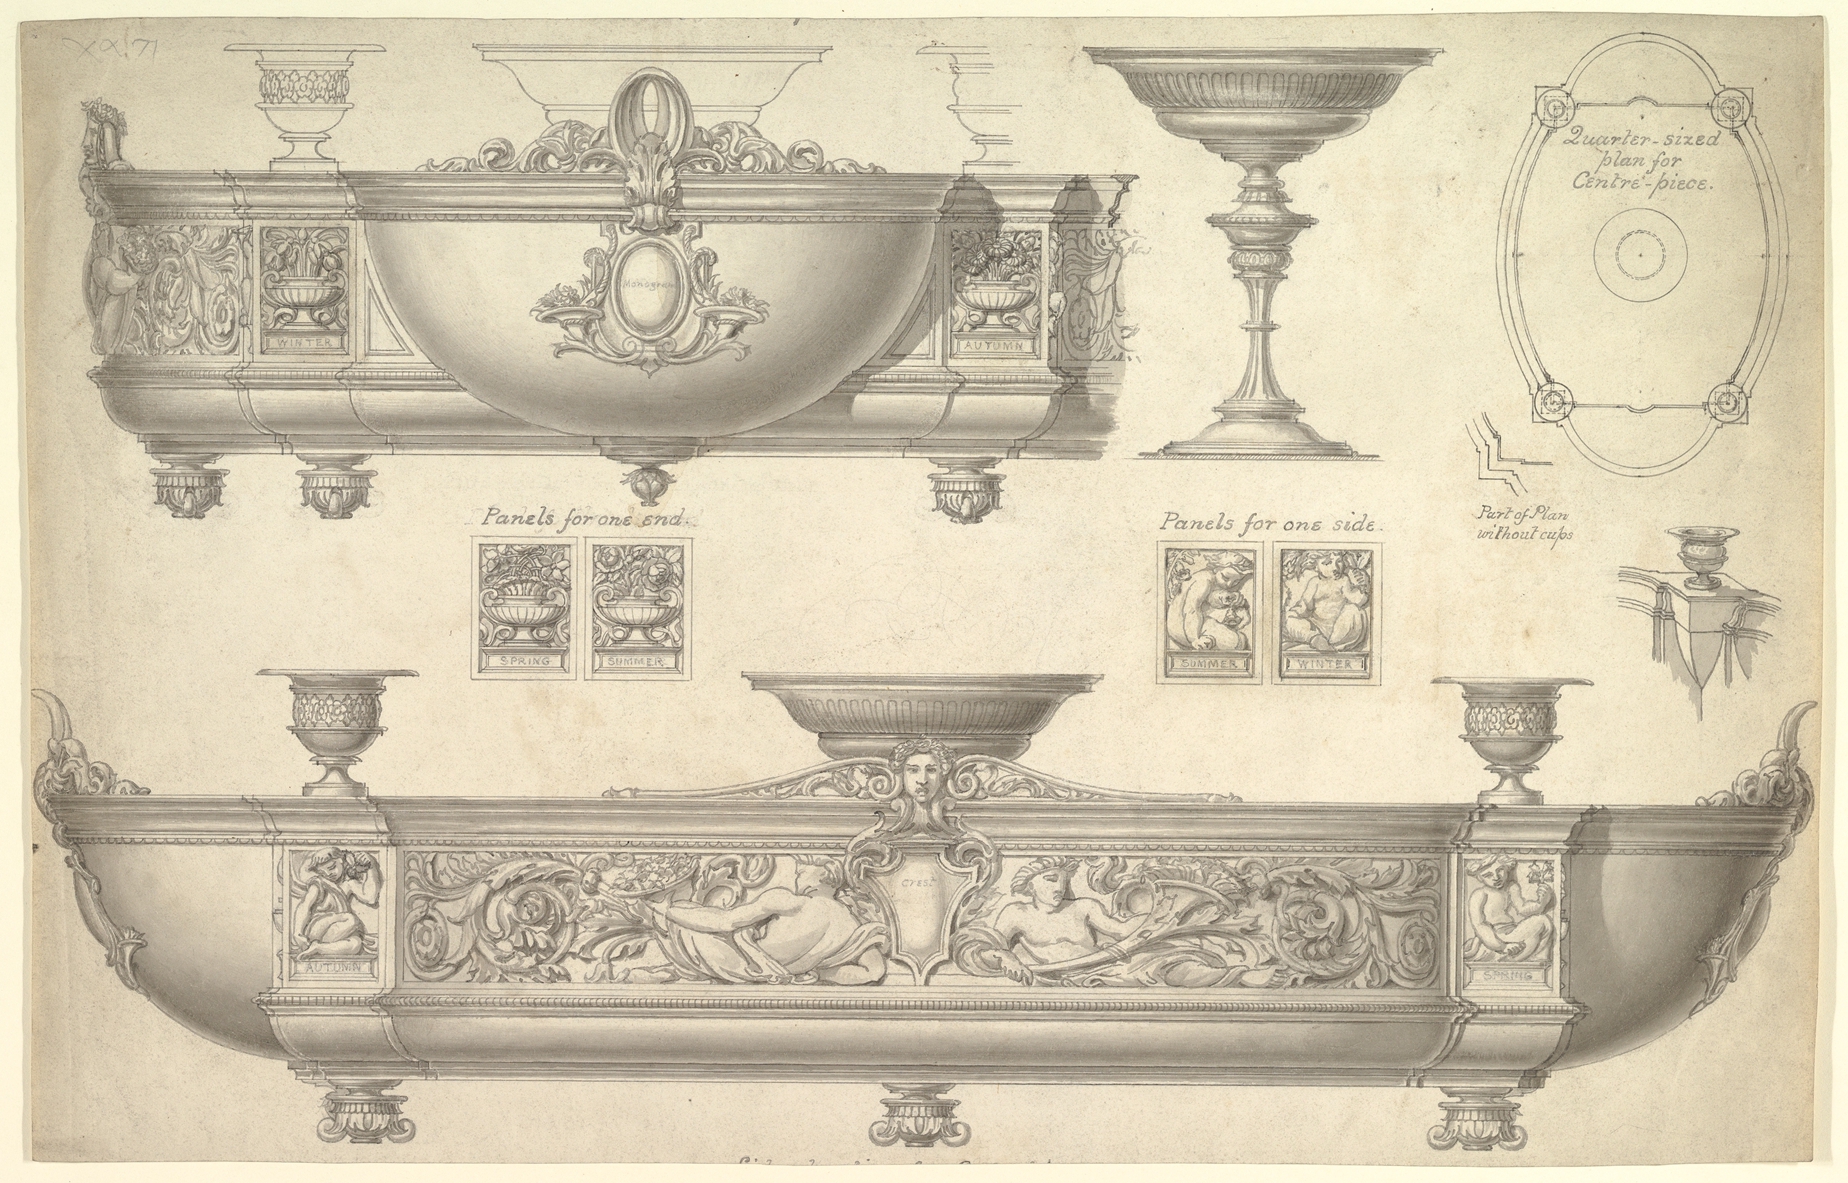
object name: drawing ornament architecture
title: Design for a Silver Centerpiece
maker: anonymous, british, 19th century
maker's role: artist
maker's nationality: british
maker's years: 1800-1900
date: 1801-1900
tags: architecture,ornament